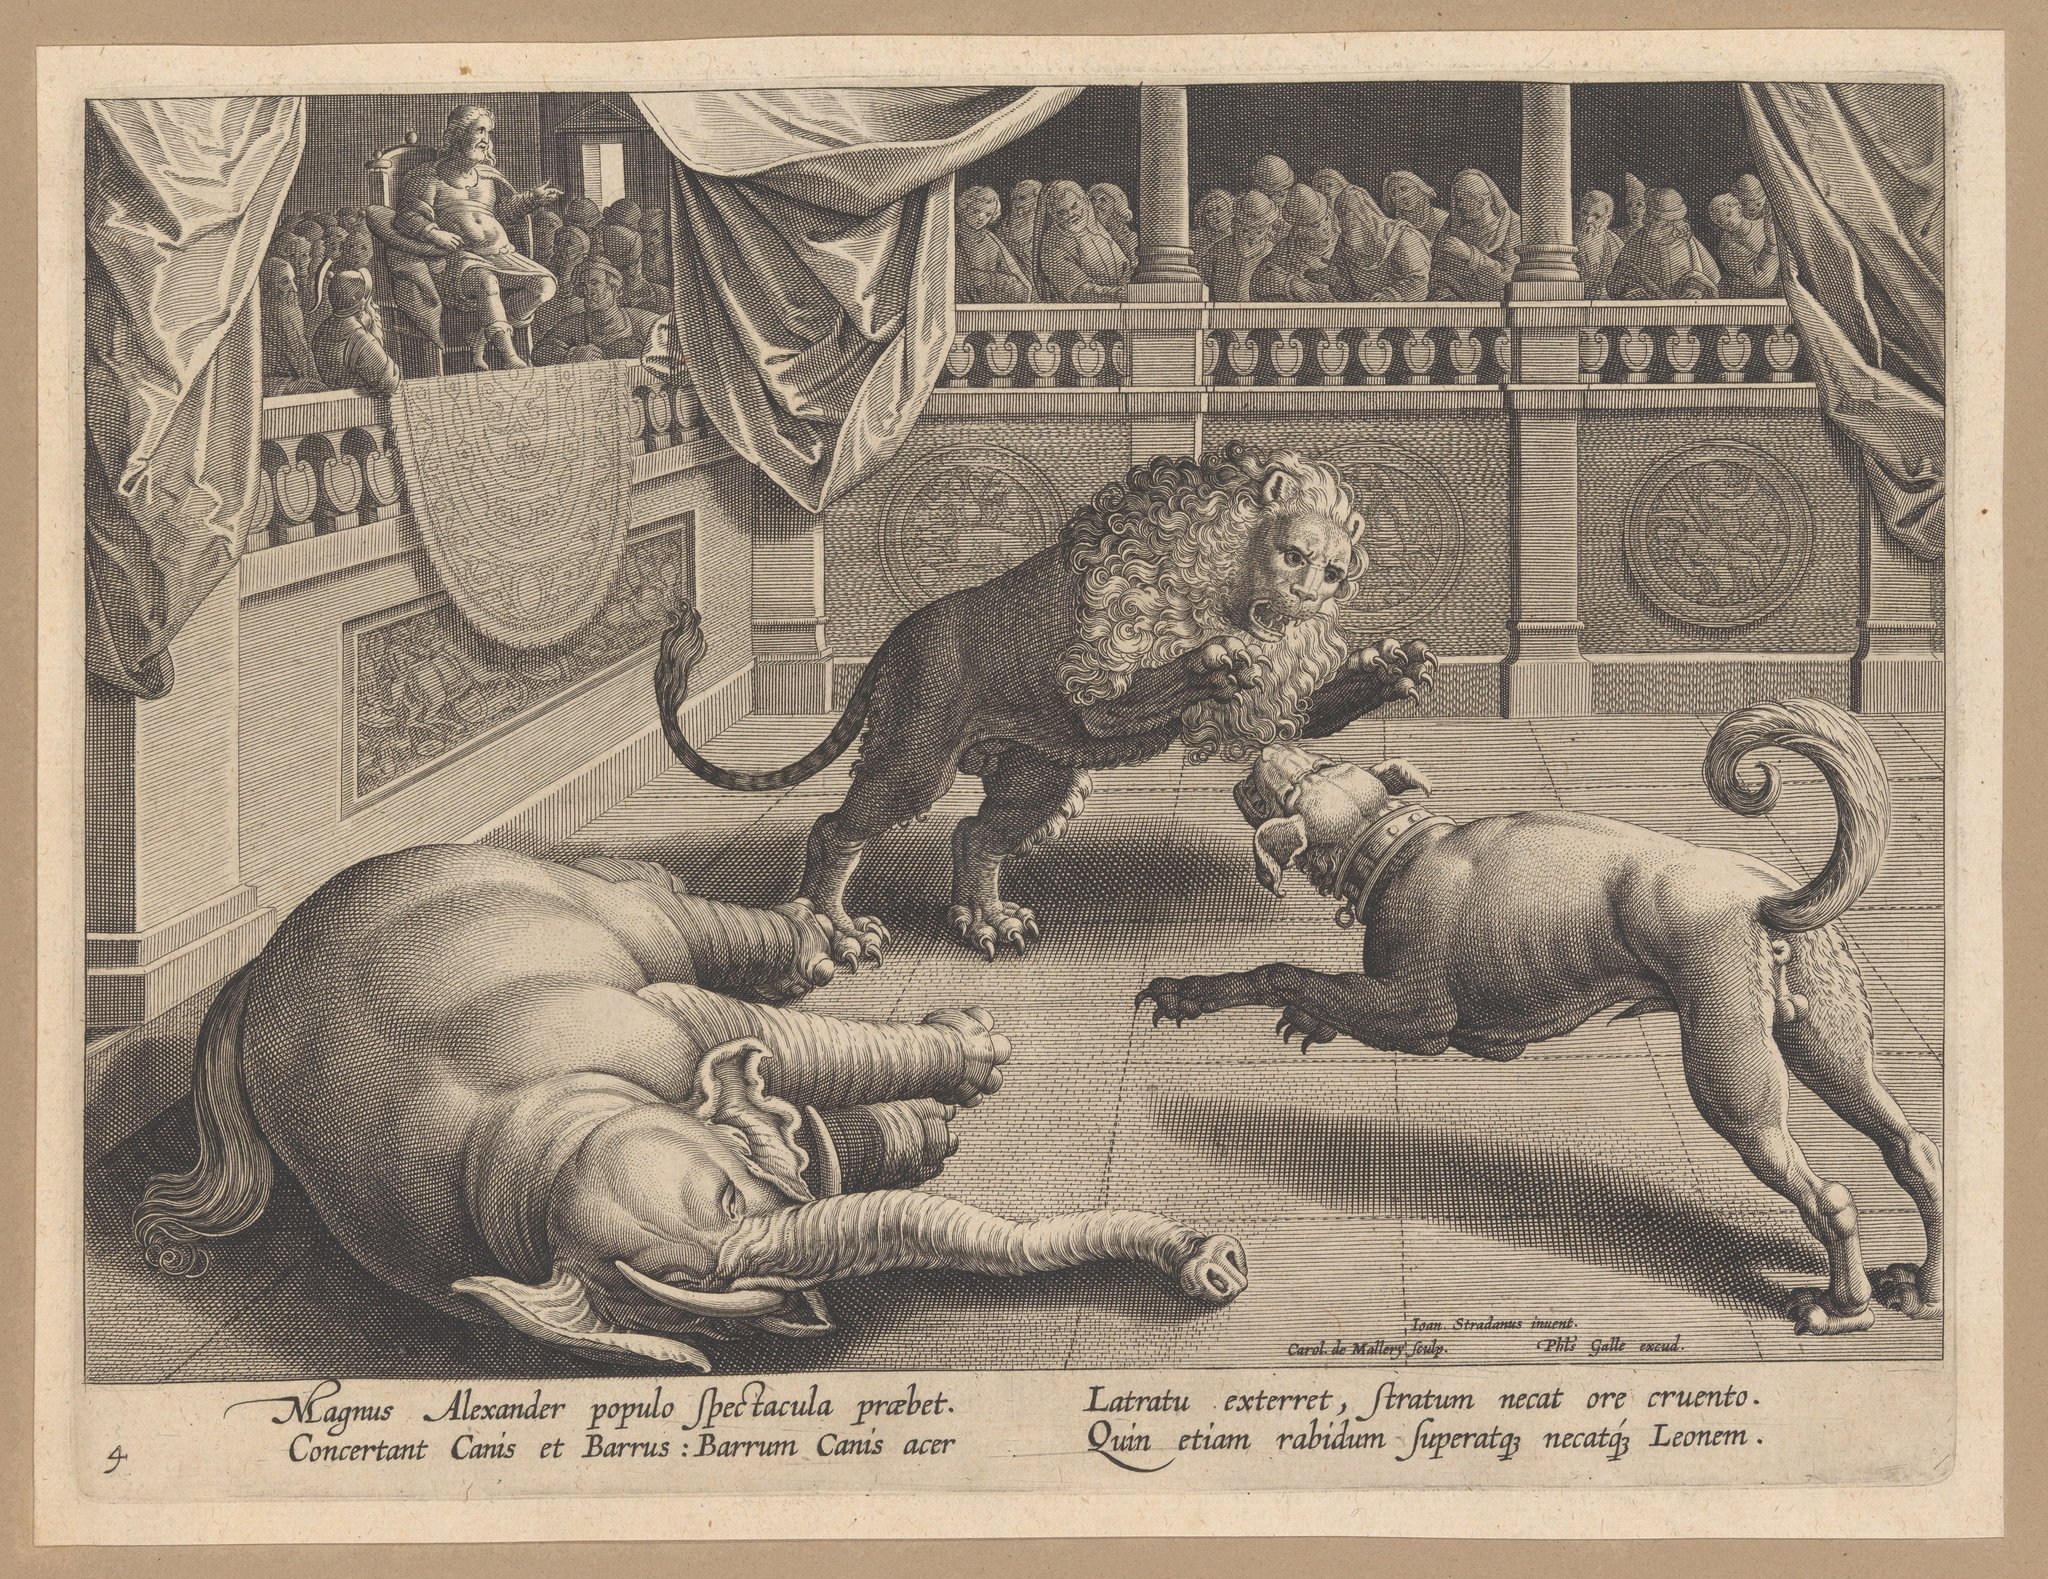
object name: book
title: Venationes ferarum avium, piscium...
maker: jan van der straet, called stradanus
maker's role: designer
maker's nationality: netherlandish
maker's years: 1523-1605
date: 1501-1600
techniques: engraving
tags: spectators,dogs,elephants,lions